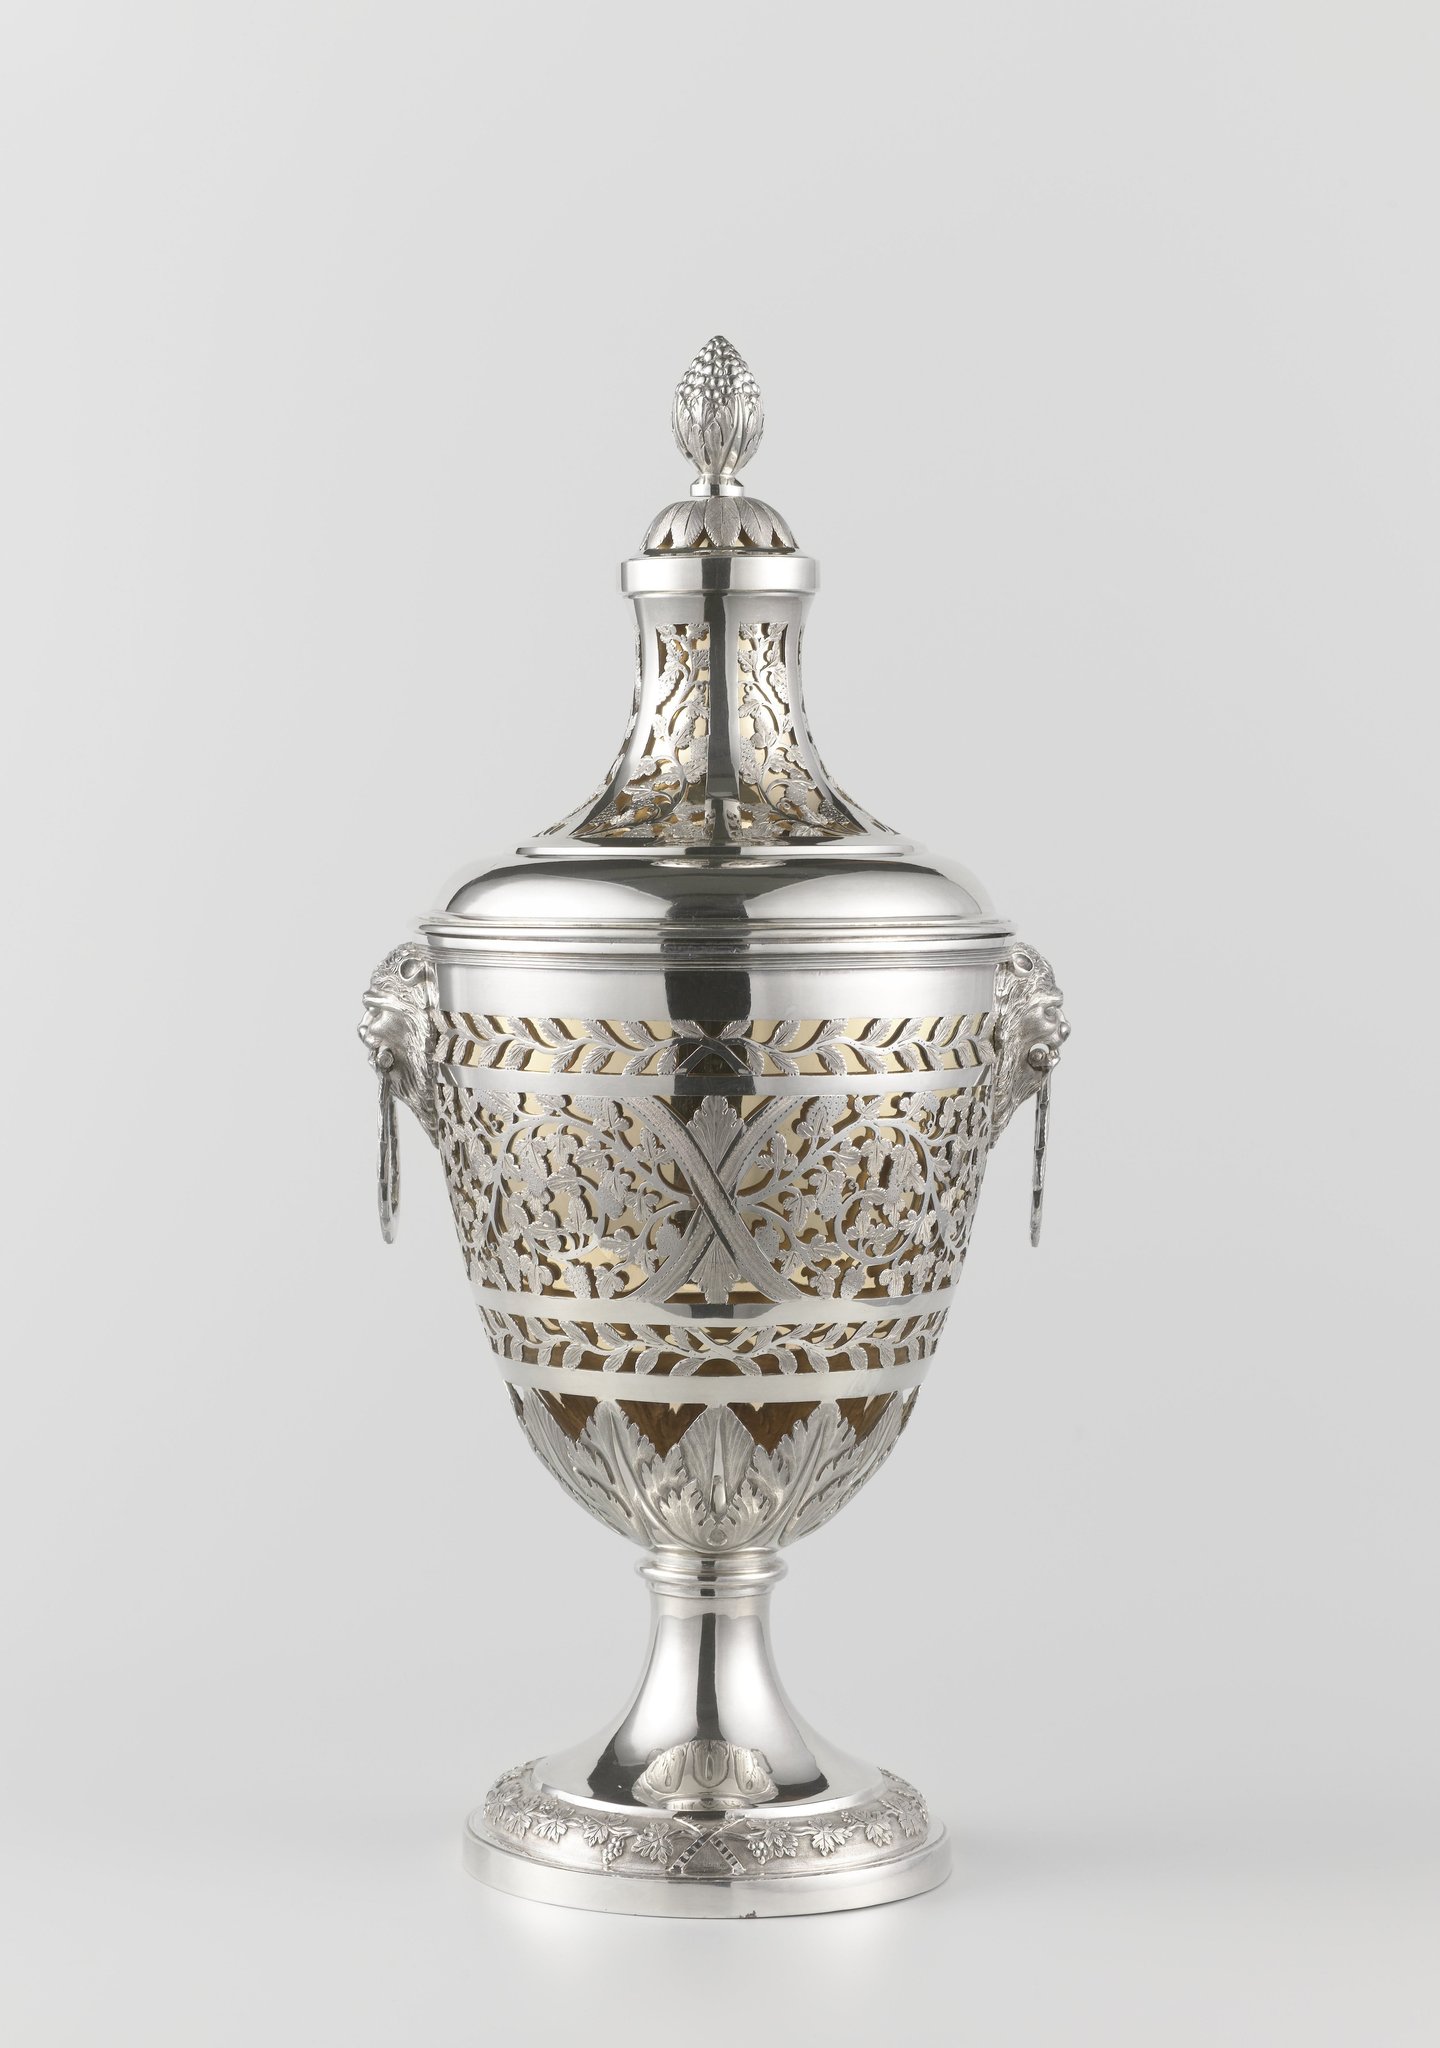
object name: vase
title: Kastanjevaas met verguld zilveren binnenwand die zichtbaar is door de opengewerkte delen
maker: francois marcus simons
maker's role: silversmith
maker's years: 1750-1828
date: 1803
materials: silver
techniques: casting, metalworking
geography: the hague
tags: vine, lion's head ~ ornament, fruits: pine-cone, foliage, tendrils, branches ~ ornament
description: Dinner service. Silver, parcel gilt. The Hague, 1803 and 1804, by François Simons. The Government of the Batavian Republic presented this service to I.J.A. Gogel (1765 - 1821) in 1804 in recognition of his financial services to the country. Gogel was a prominent patriot, minister of finance under King Louis Napoleon and subsequently financial advisor to King